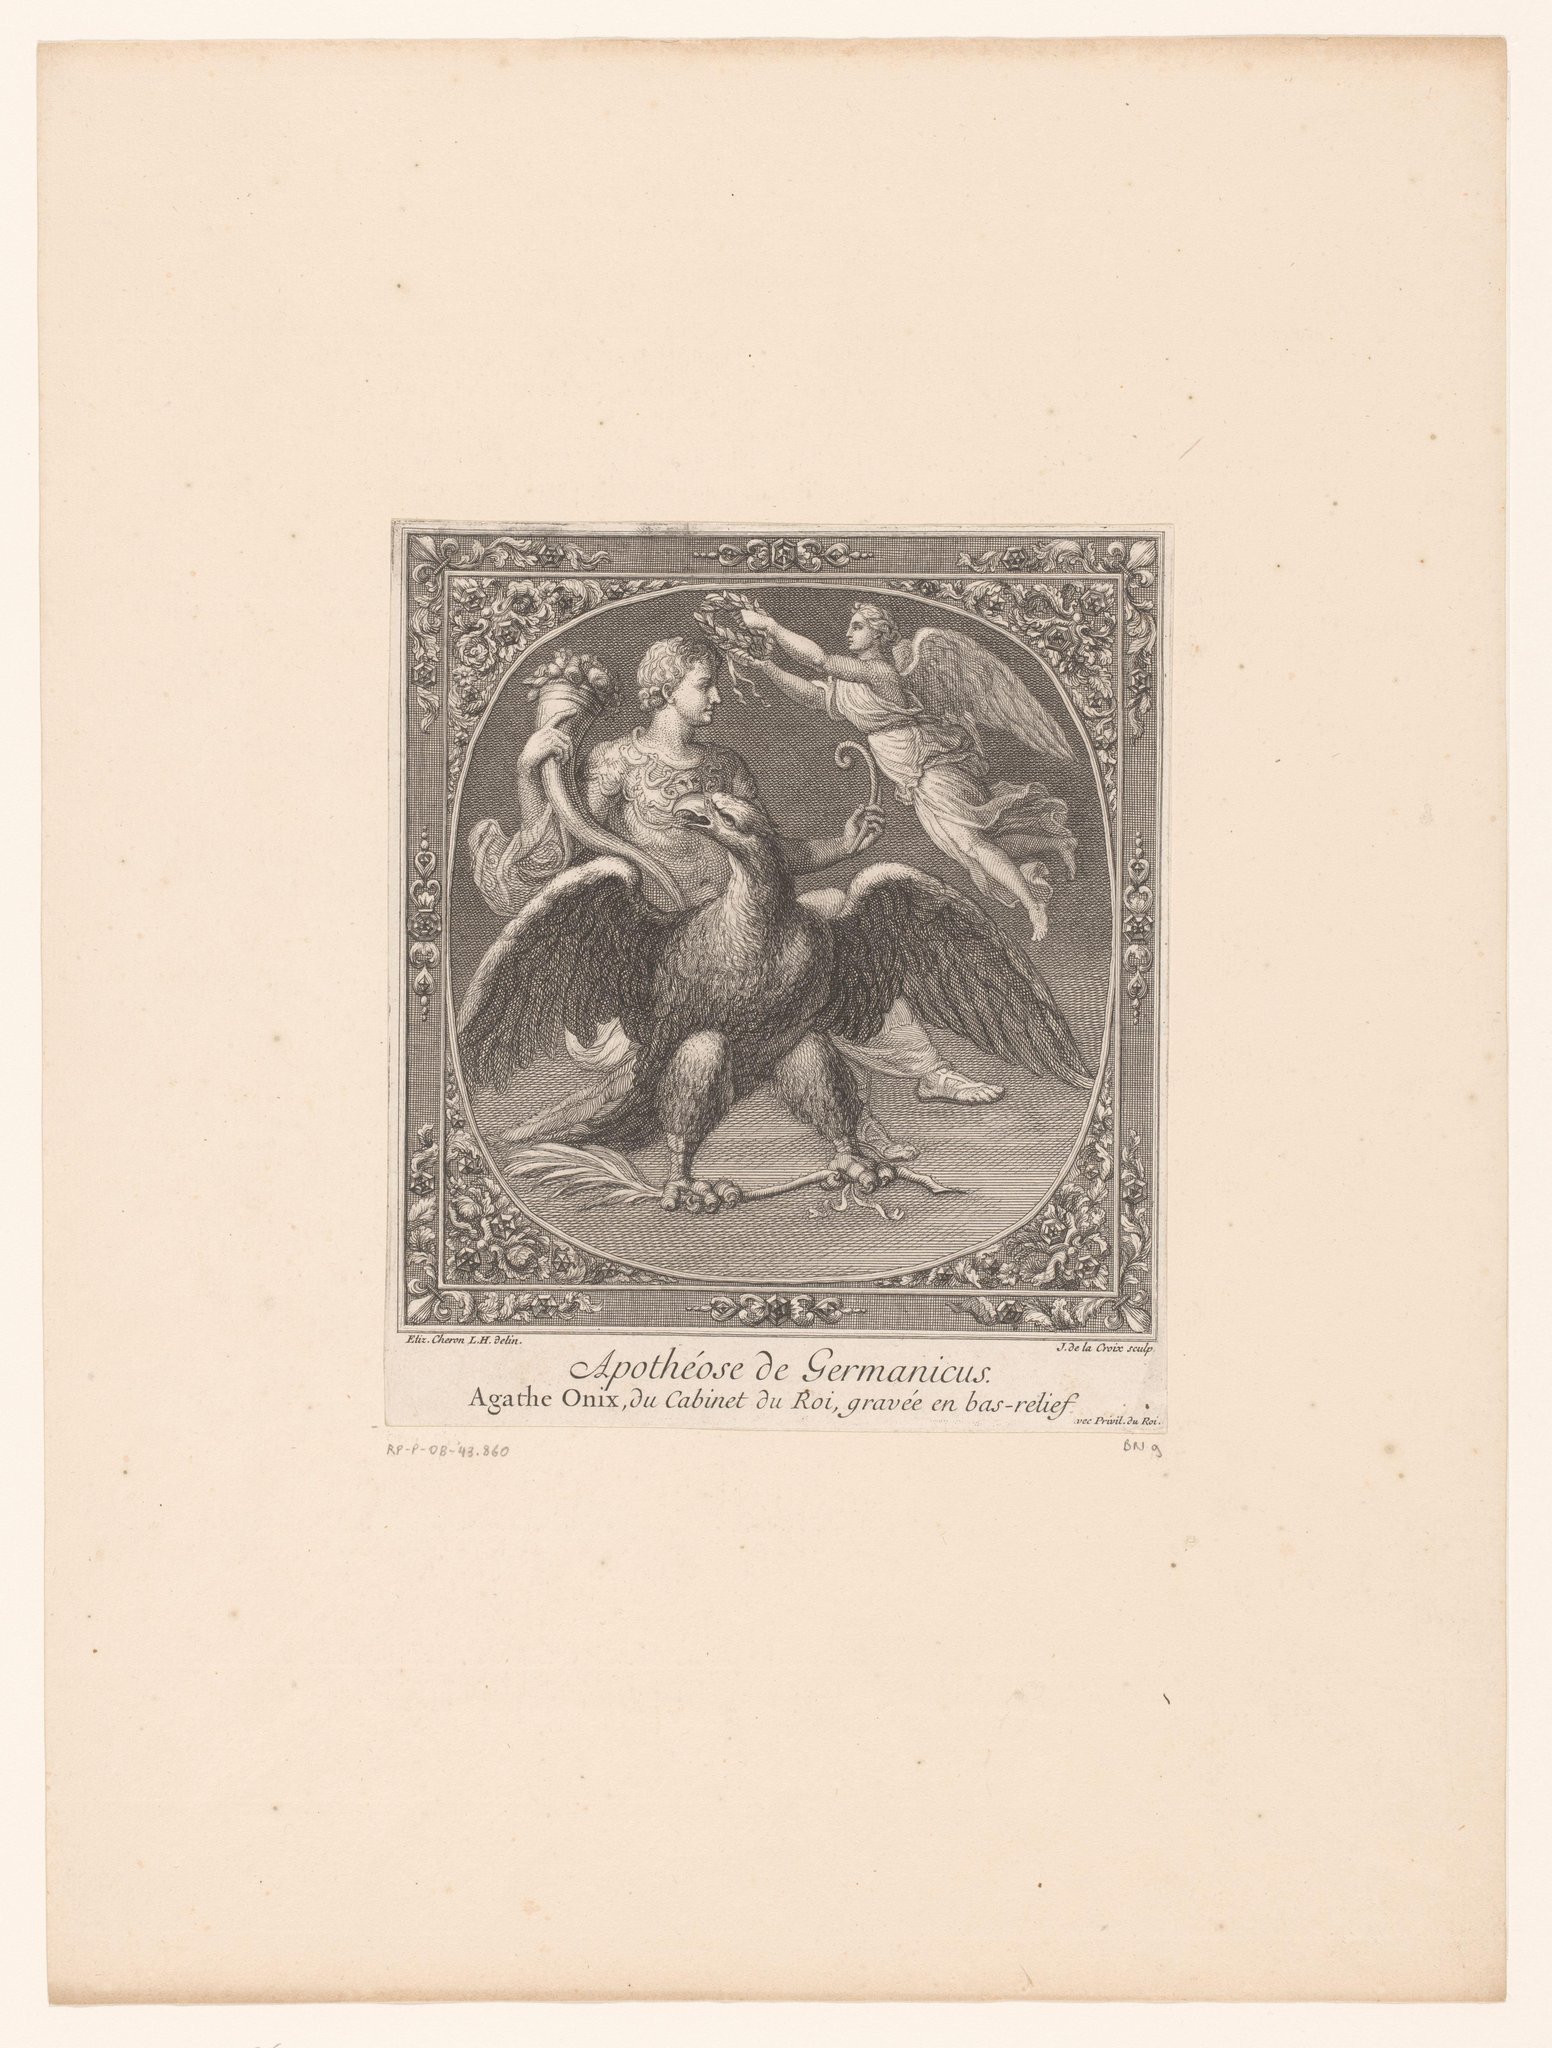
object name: print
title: Apothéose de Germanicus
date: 1700-1799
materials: paper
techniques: engraving, etching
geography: france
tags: predatory birds: eagle, historical persons, apotheosis of a ruler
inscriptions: collector's mark: Lugt 2228